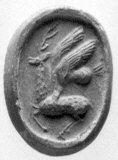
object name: stamp seal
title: Scaraboid seal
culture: cypriot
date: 700-501 BCE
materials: stone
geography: cyprus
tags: scarabs